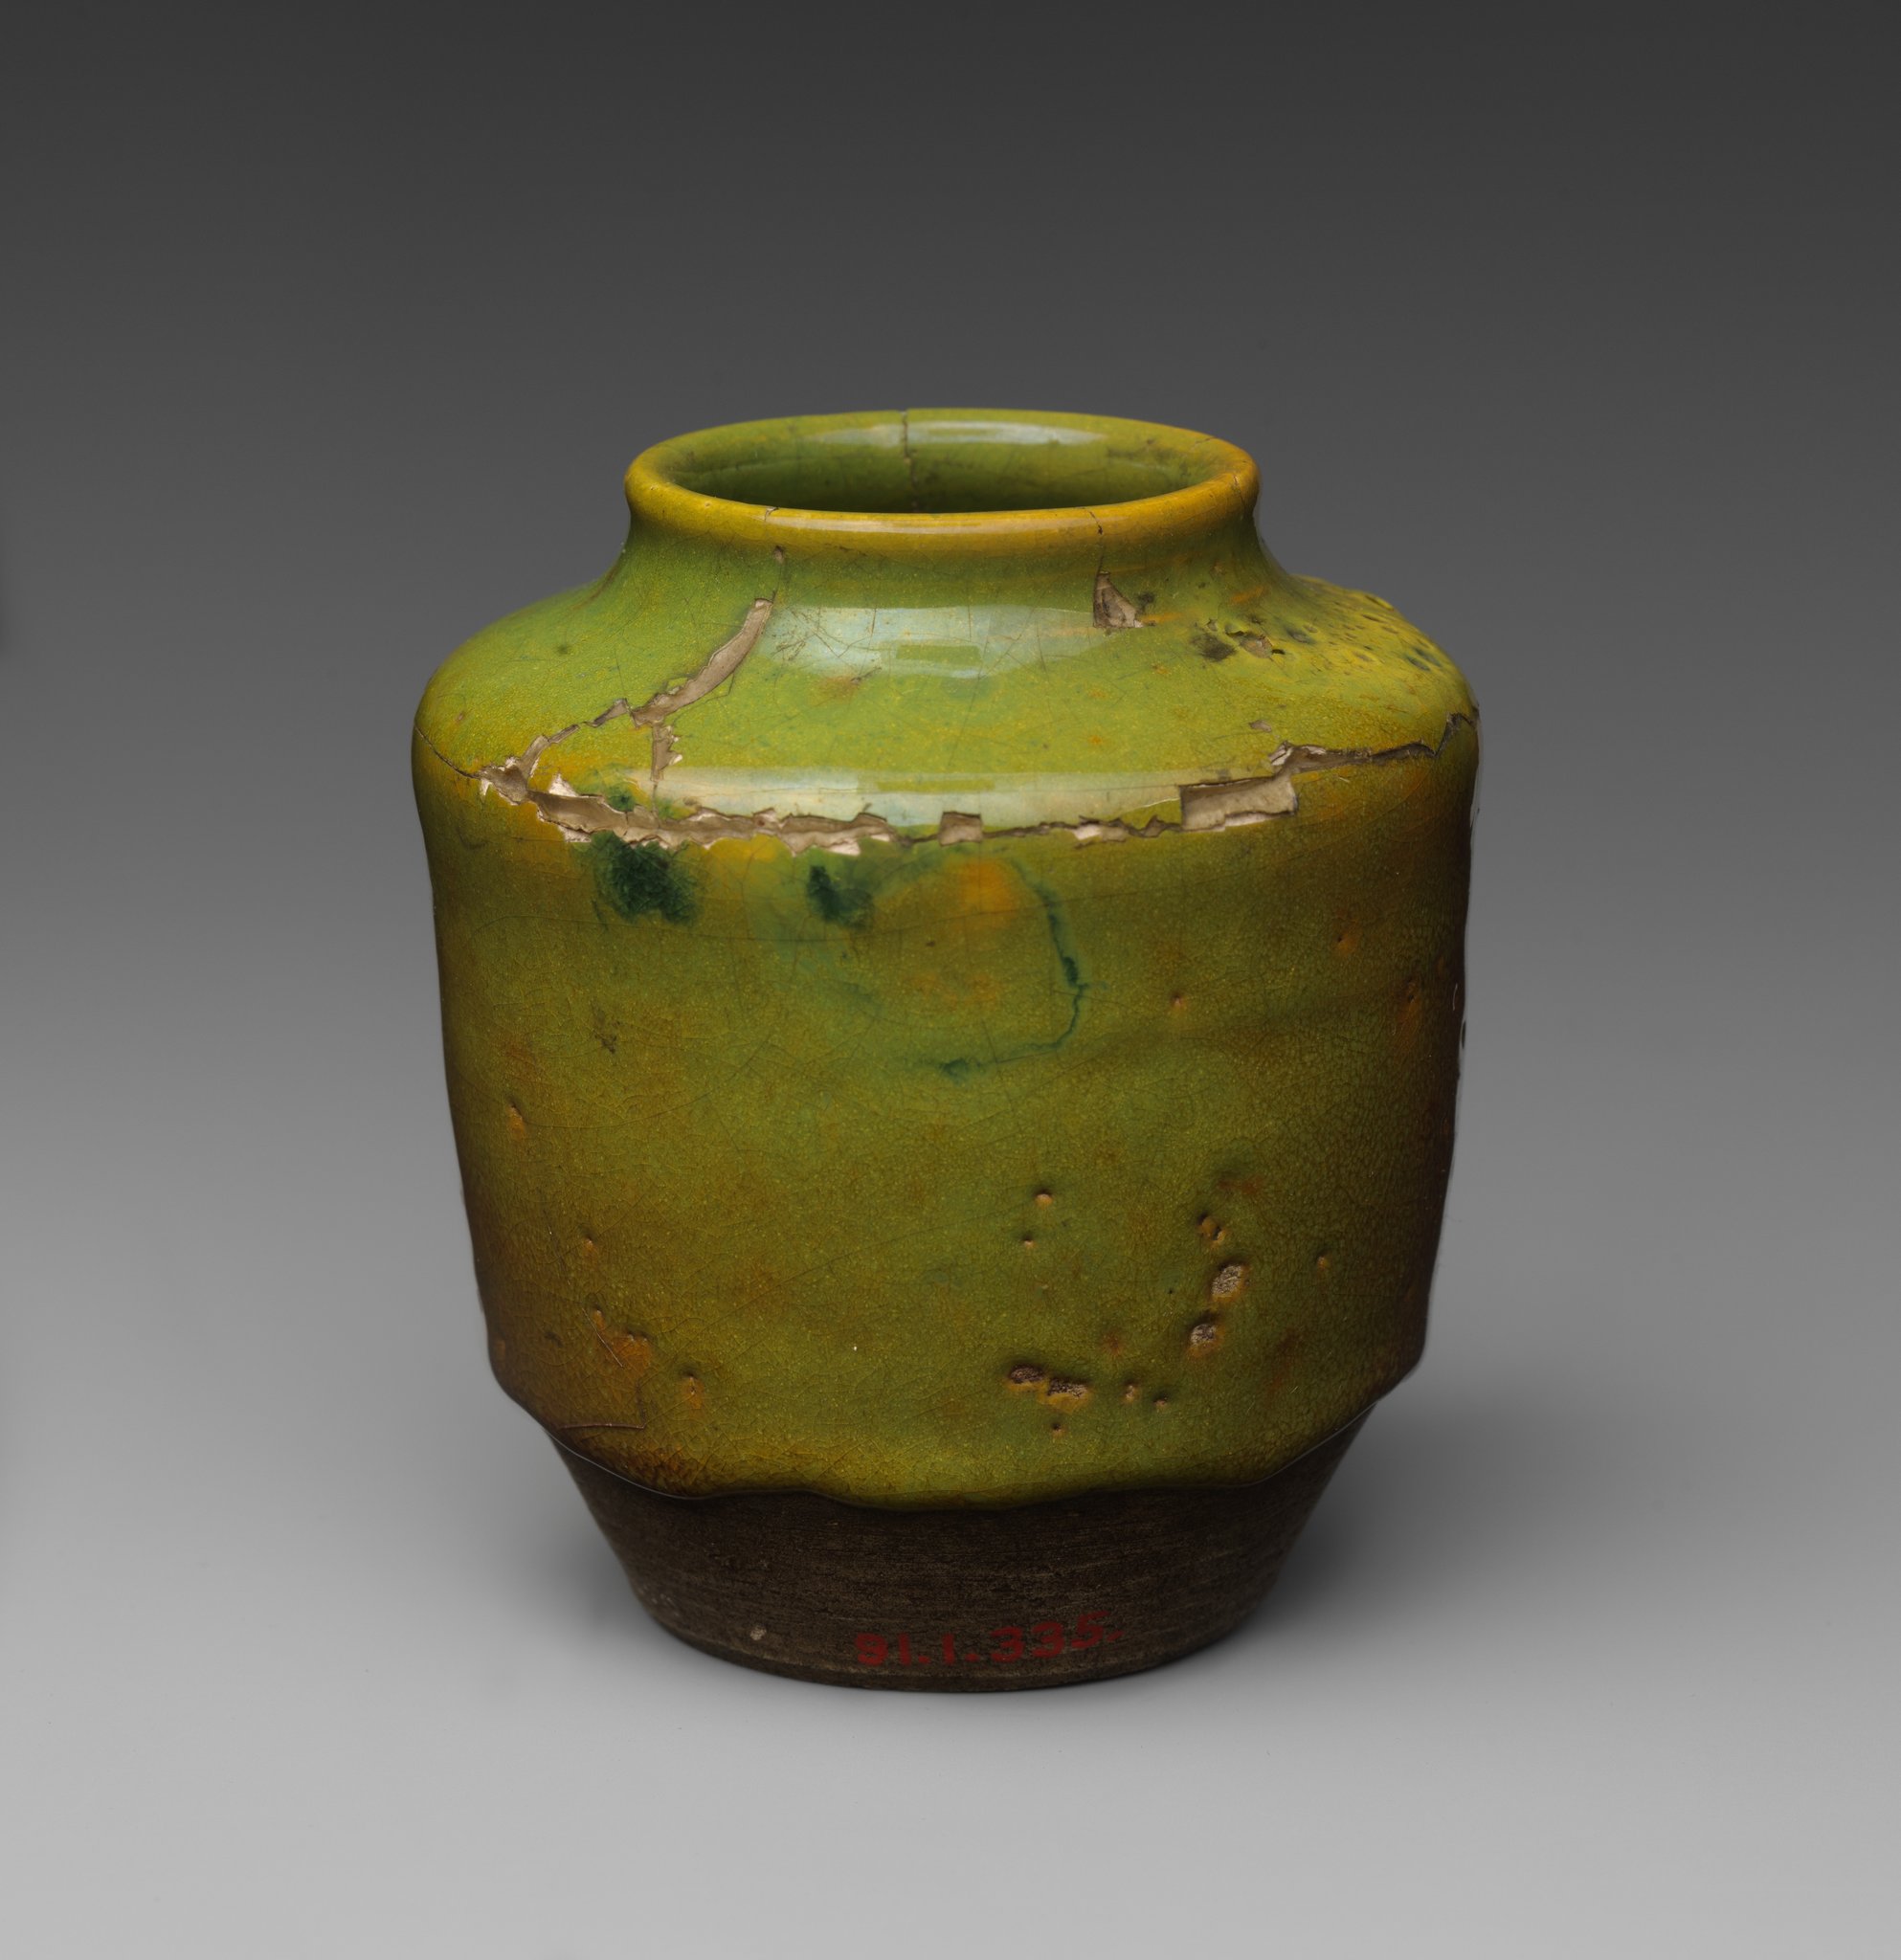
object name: tea jar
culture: japanese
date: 1801-1900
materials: clay, glaze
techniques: stain